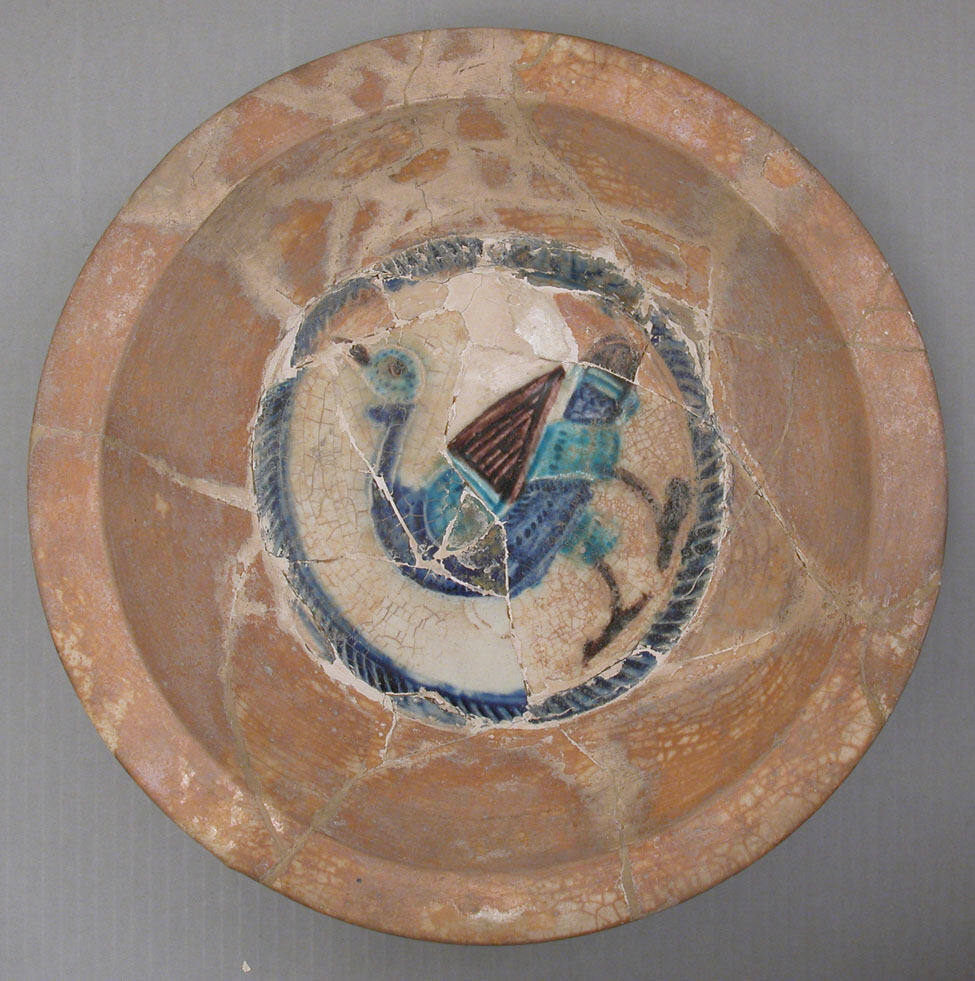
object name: bowl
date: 1101-1200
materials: earthenware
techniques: glazing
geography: syria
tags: birds